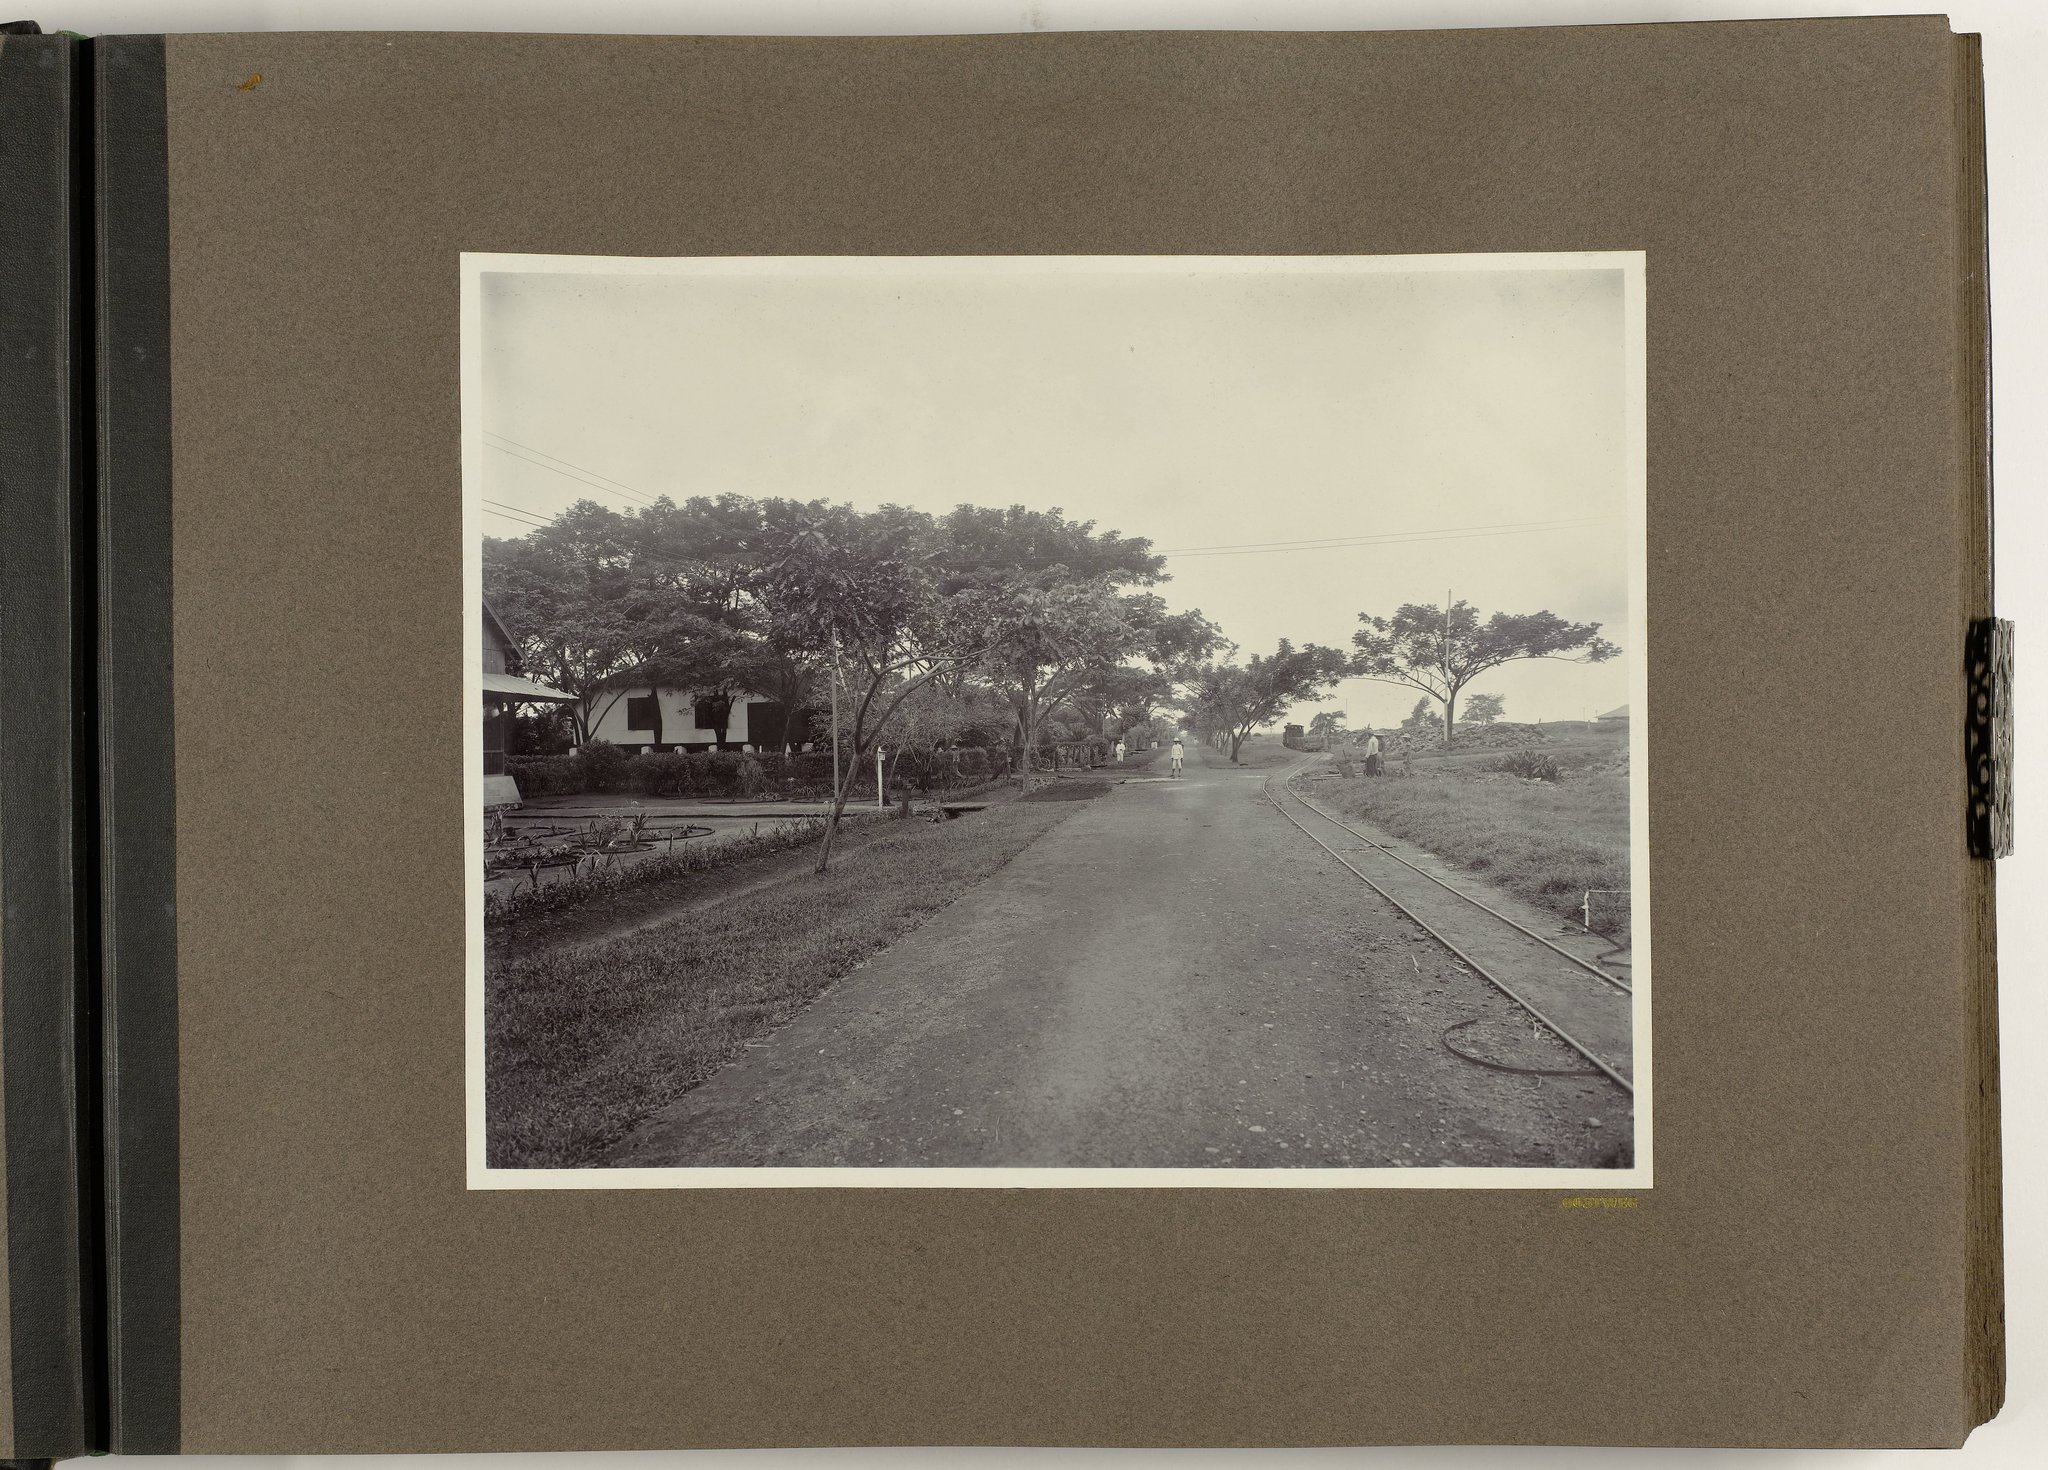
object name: photograph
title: Oostweg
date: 1917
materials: photographic support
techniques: gelatin silver print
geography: jatiroto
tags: colonial system, road, path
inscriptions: inscription: ‘OOSTWEG’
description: De Oostweg met mensen, links bomen en huizen en rechts een spoorlijn waarop een treintje. In de lucht elektriciteitsdraden. Onderdeel van het fotoalbum aangeboden aan F.J. Wirix door het personeel van de Suikeronderneming Djatiroto in 1917.